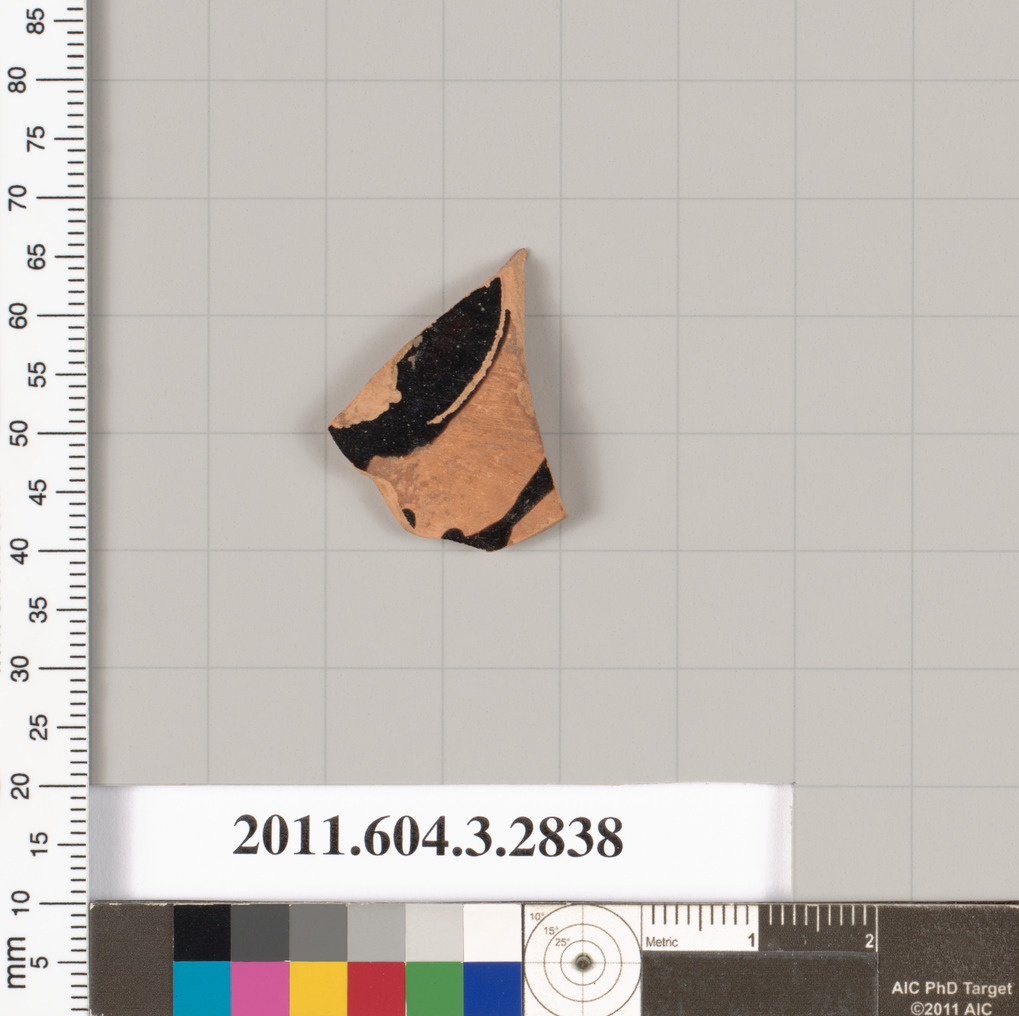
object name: undetermined closed shape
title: Terracotta fragment of a closed shape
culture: greek, attic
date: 534-468 BCE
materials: terracotta